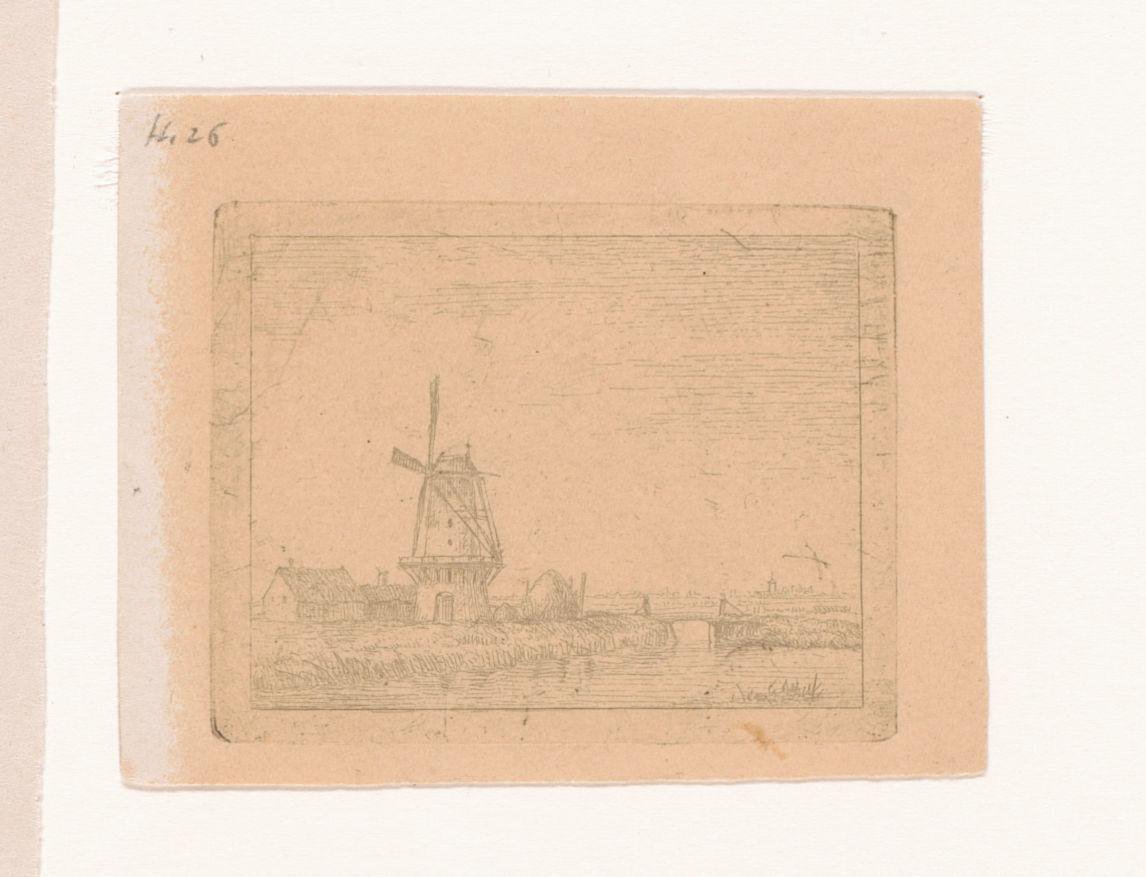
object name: print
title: Stenen windmolen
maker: eugène verboeckhoven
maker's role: draughtsman, painter, print maker, printer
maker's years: 1798-1881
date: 1808-1881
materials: paper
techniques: etching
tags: windmill in landscape, windmill